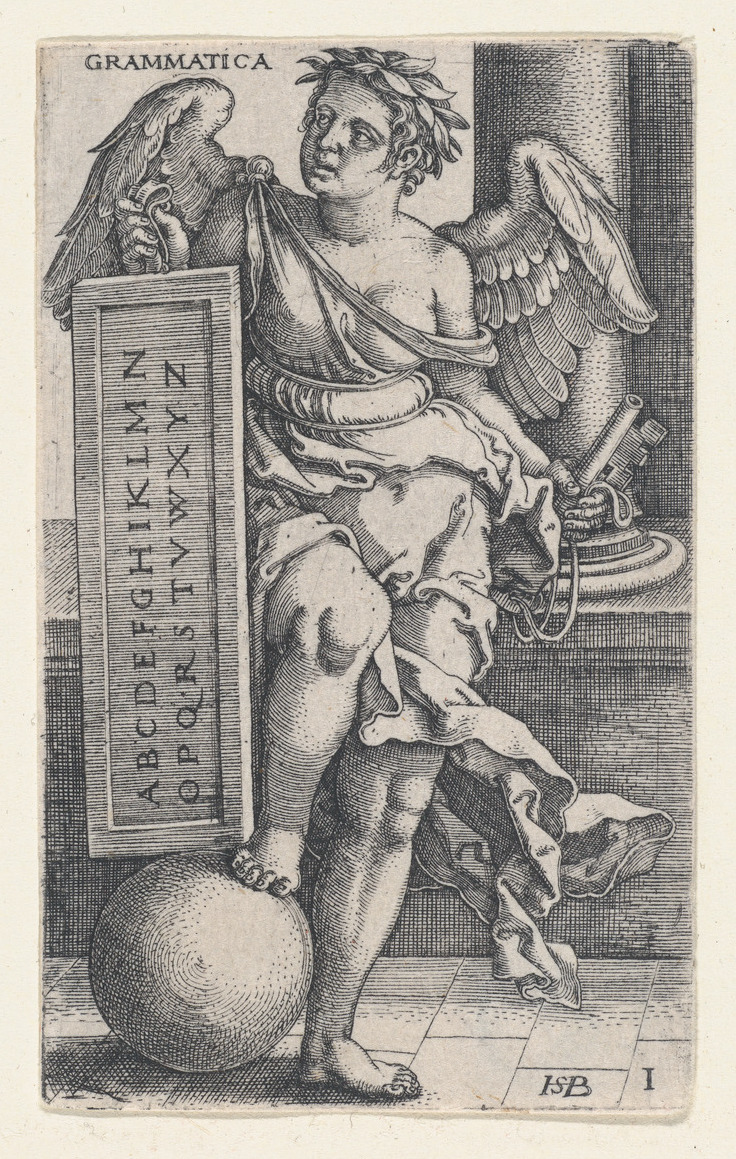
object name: print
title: Grammatica, from "The Seven Liberal Arts"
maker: sebald beham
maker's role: artist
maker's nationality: german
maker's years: 1500-1550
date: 1500-1550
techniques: engraving